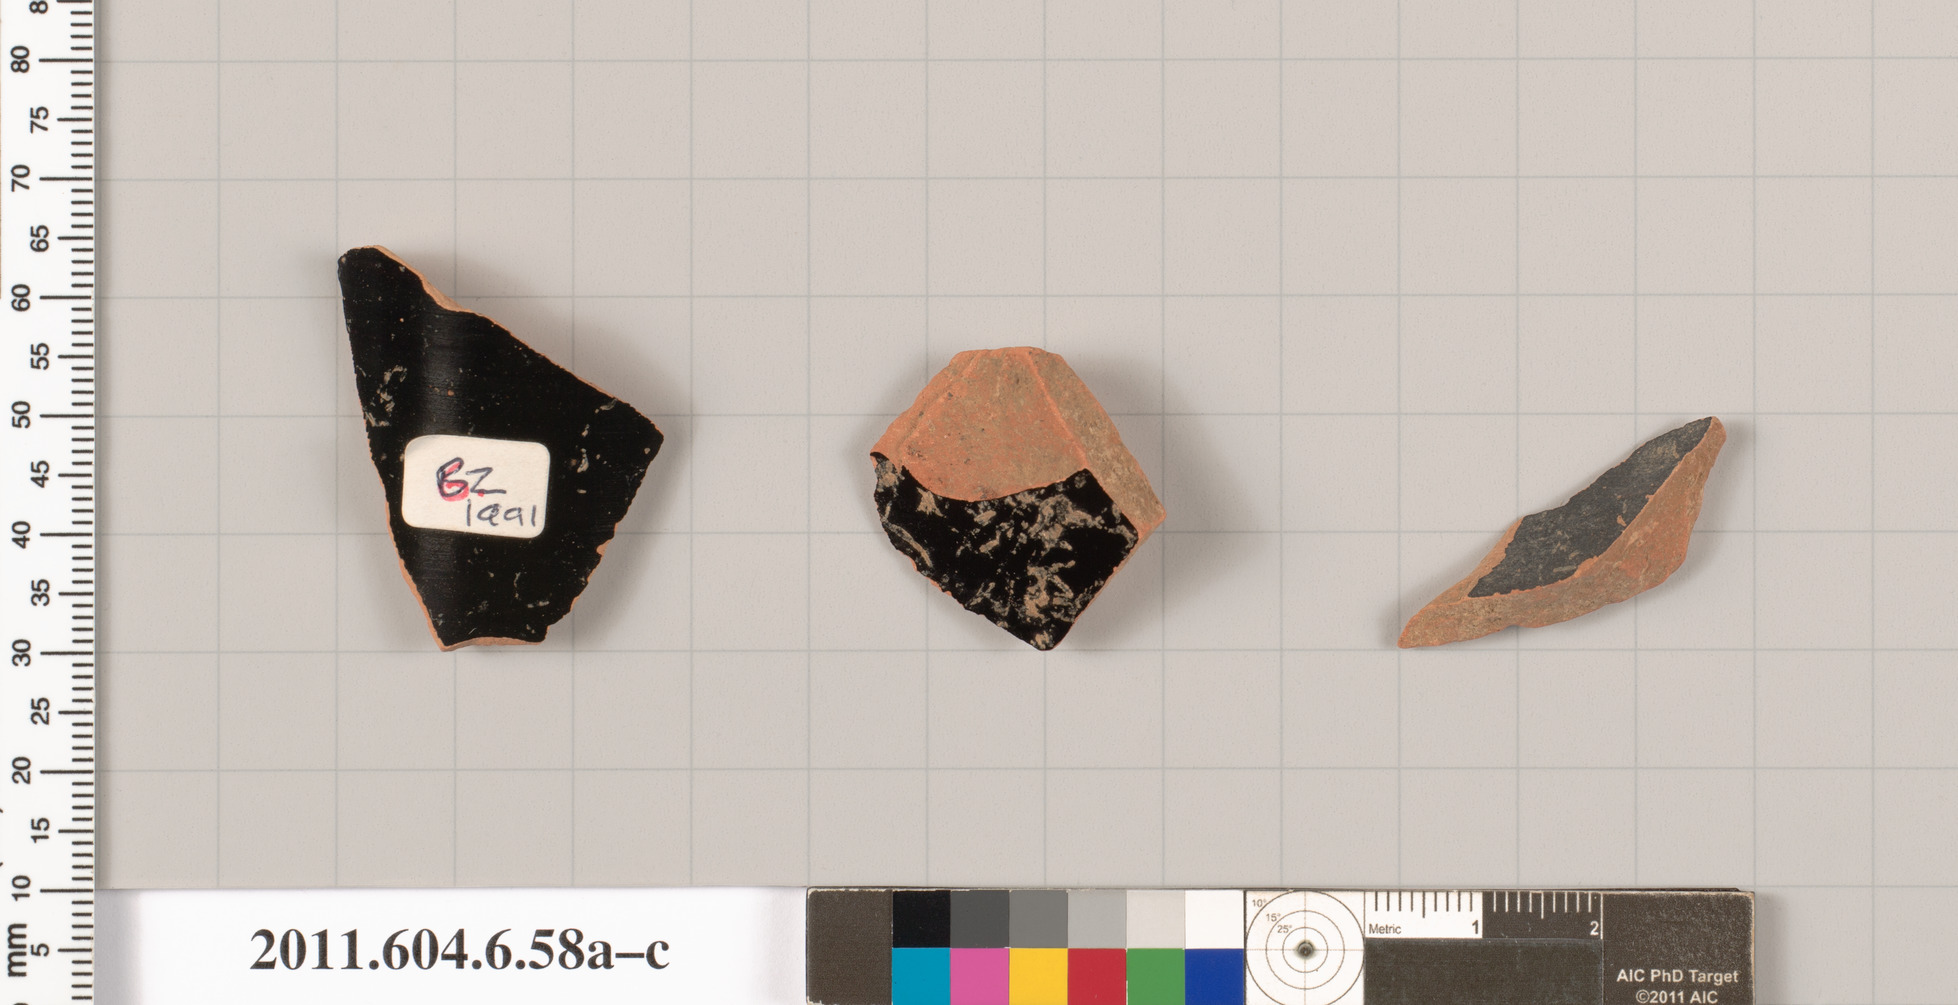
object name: undetermined shape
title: Terracotta fragments of undetermined shapes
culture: greek, attic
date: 600-401 BCE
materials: terracotta